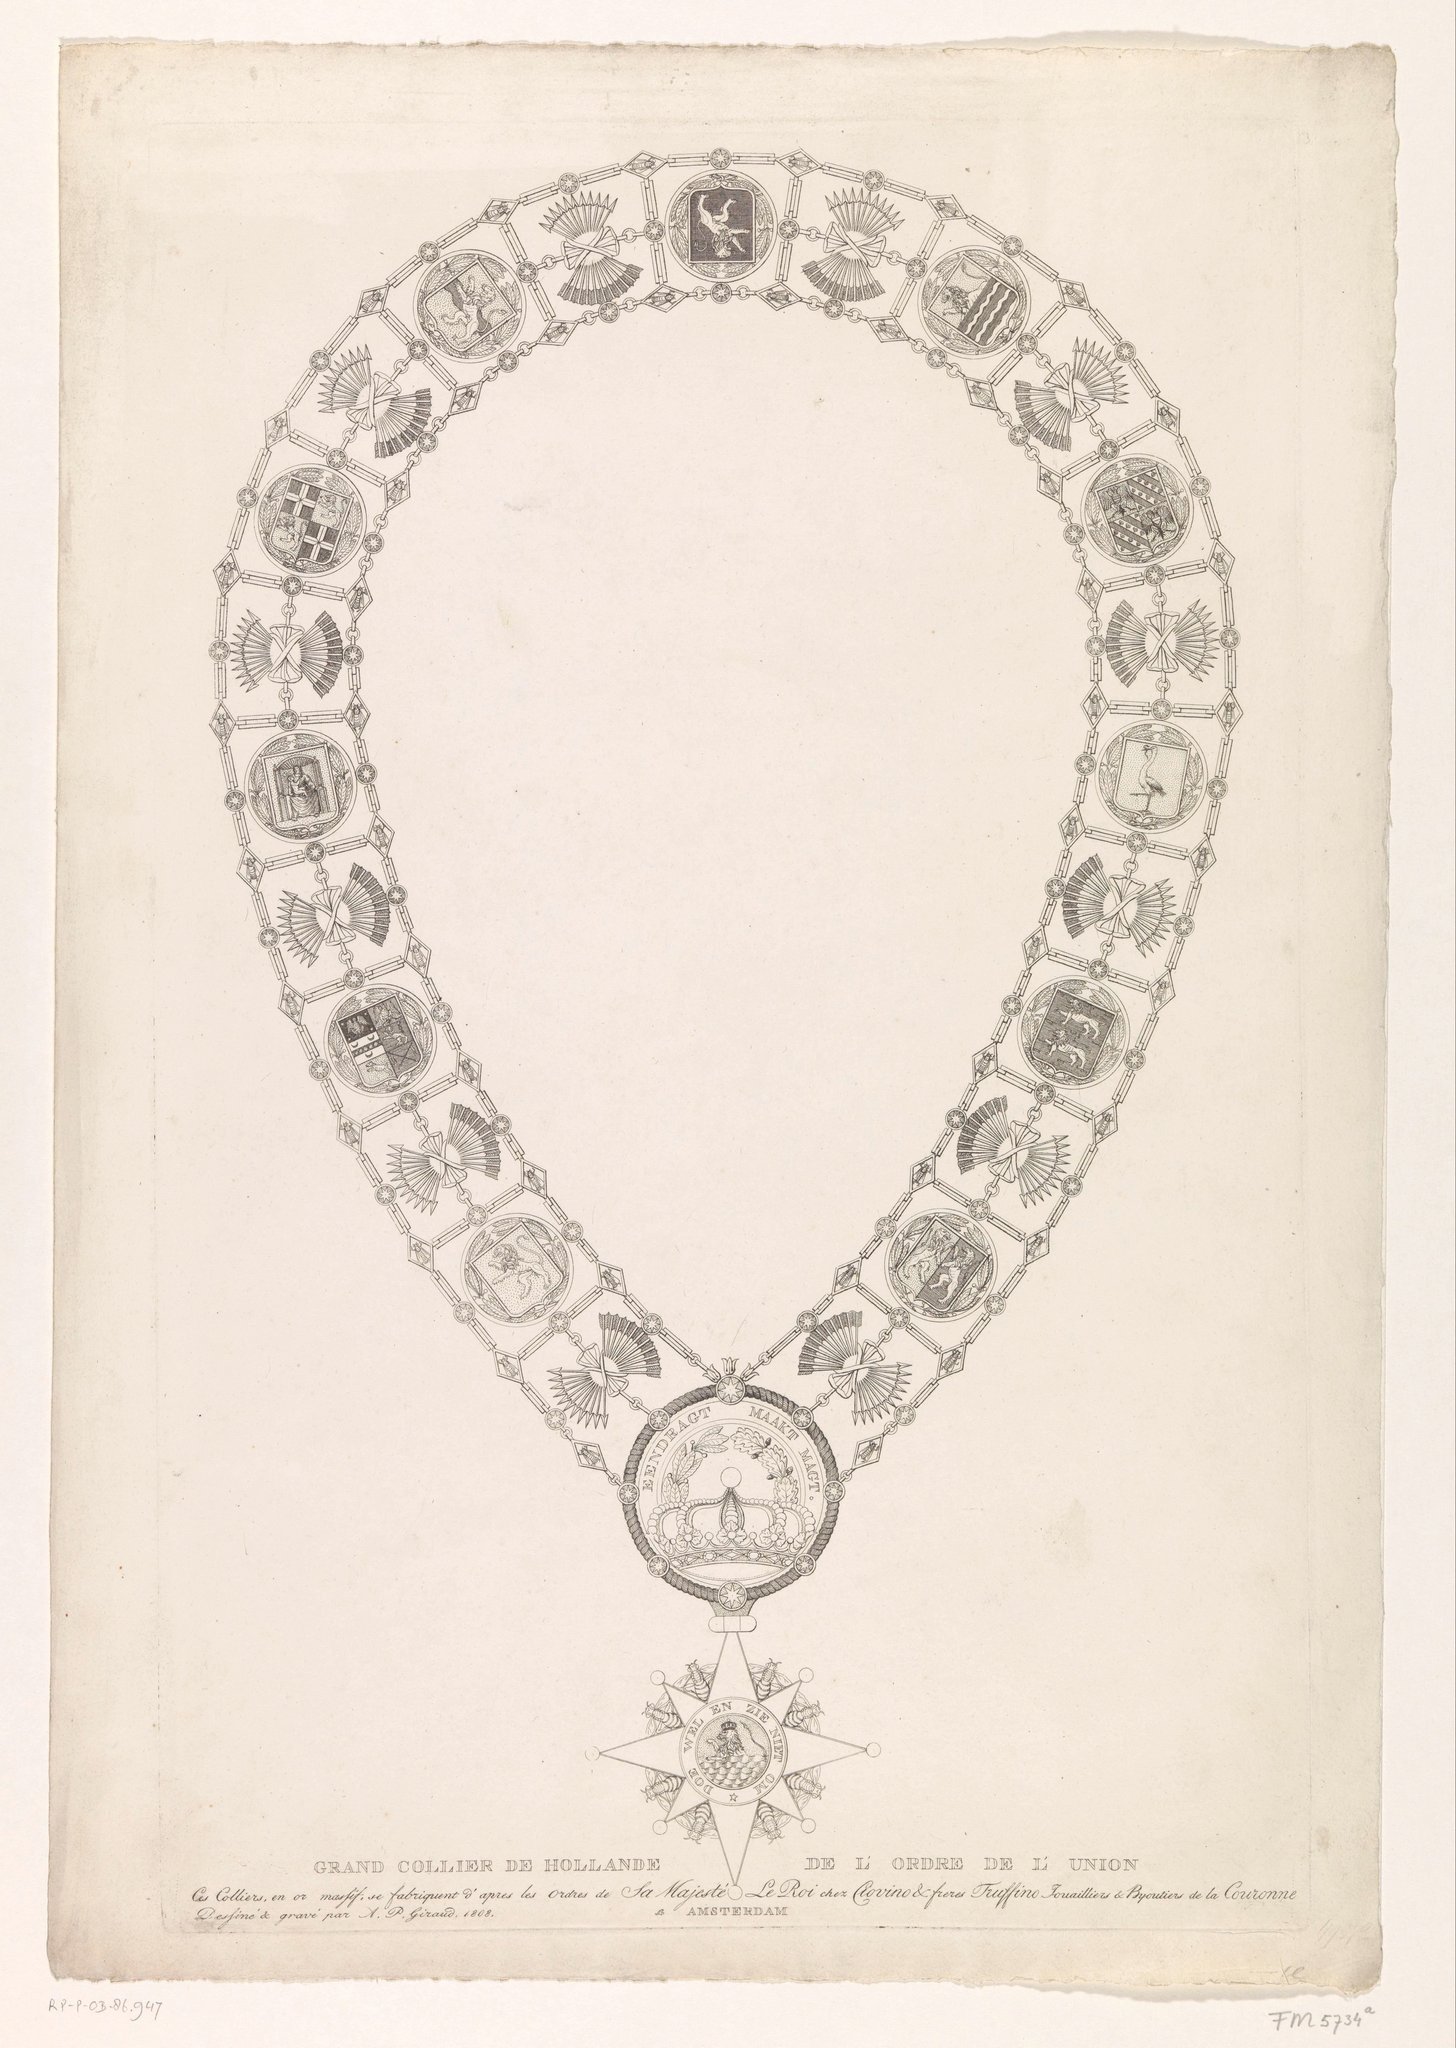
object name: print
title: Grand collier de Hollande de l'ordre de l'union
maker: alphonse pierre giraud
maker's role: print maker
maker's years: 1786-1863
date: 1808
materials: paper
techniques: etching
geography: amsterdam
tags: louis napoleon (king of holland), knighthood order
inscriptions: collector's mark: Lugt 2228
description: Het Grote Keten met het kruis van de Koninklijke Orde van Holland, later genoemd Orde van de Unie. Onderscheiding ingesteld door koning Lodewijk Napoleon, voor het eerst in 1806. Deze variant van het versiersel met een zwemmende of uitkomende leeuw dateert van 14 februari 1807. Op ware grootte.